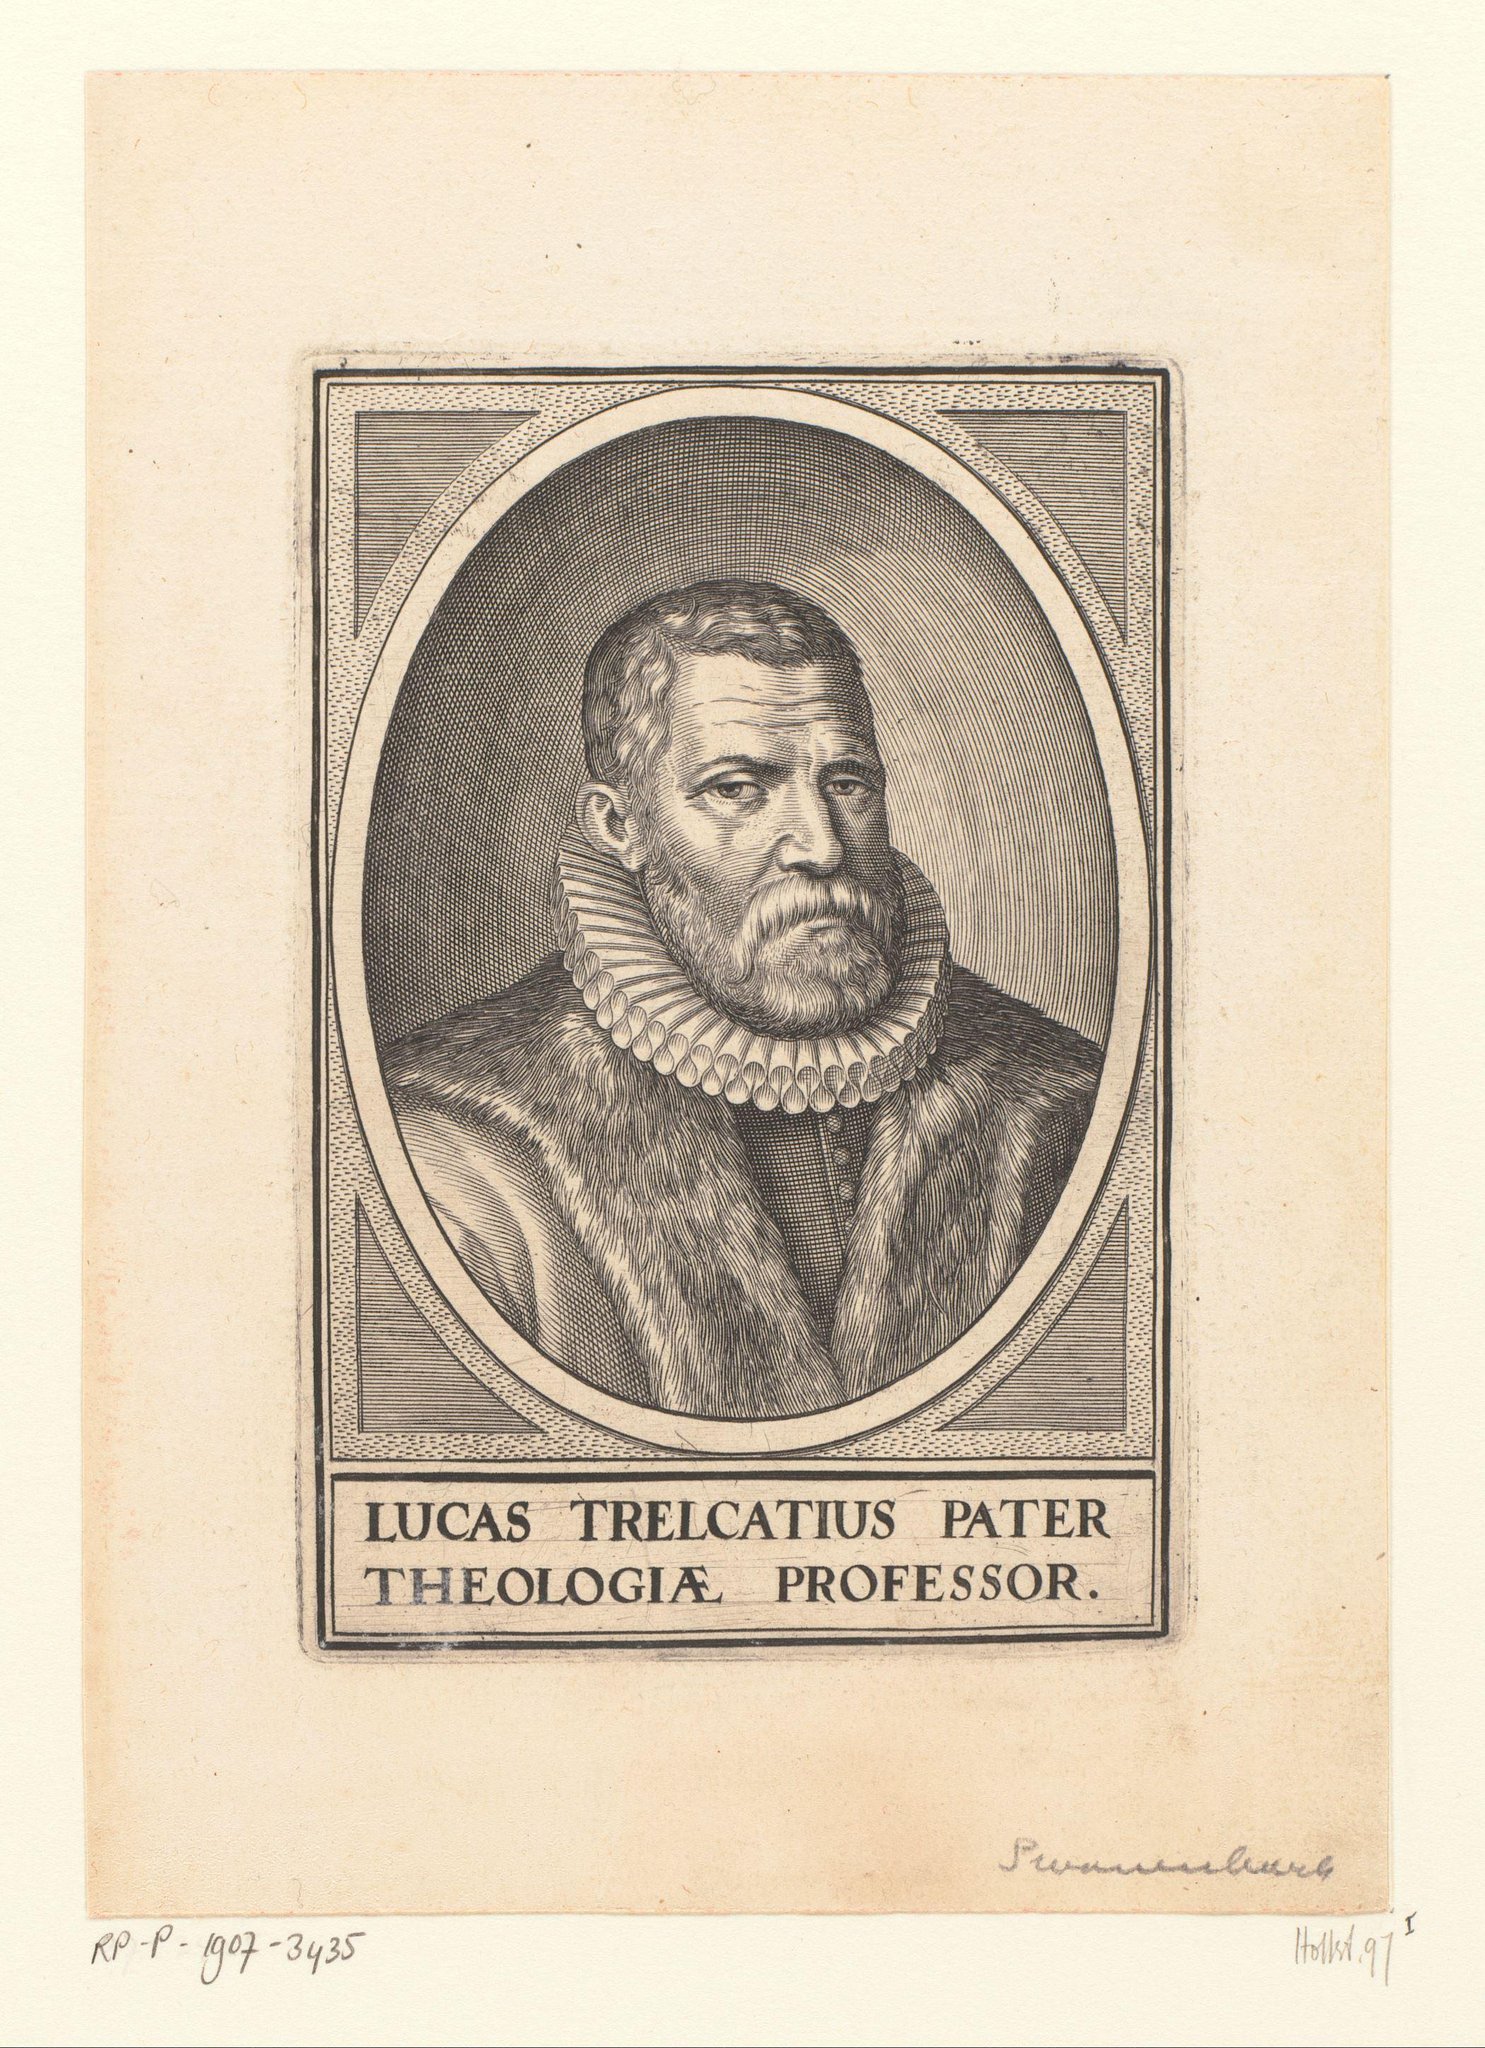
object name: book illustration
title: Portret van Lucas Trelcatius (I)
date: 1609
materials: paper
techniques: engraving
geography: leiden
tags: france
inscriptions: collector's mark: Lugt 2228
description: Prent uit: Icones ad vivum delineatæ et expressæ, virorvm clariorvm qui præcipue scriptis Academiam Lvgdvno Batavam illustrarunt. Leiden: Andries Clouck, 1609.